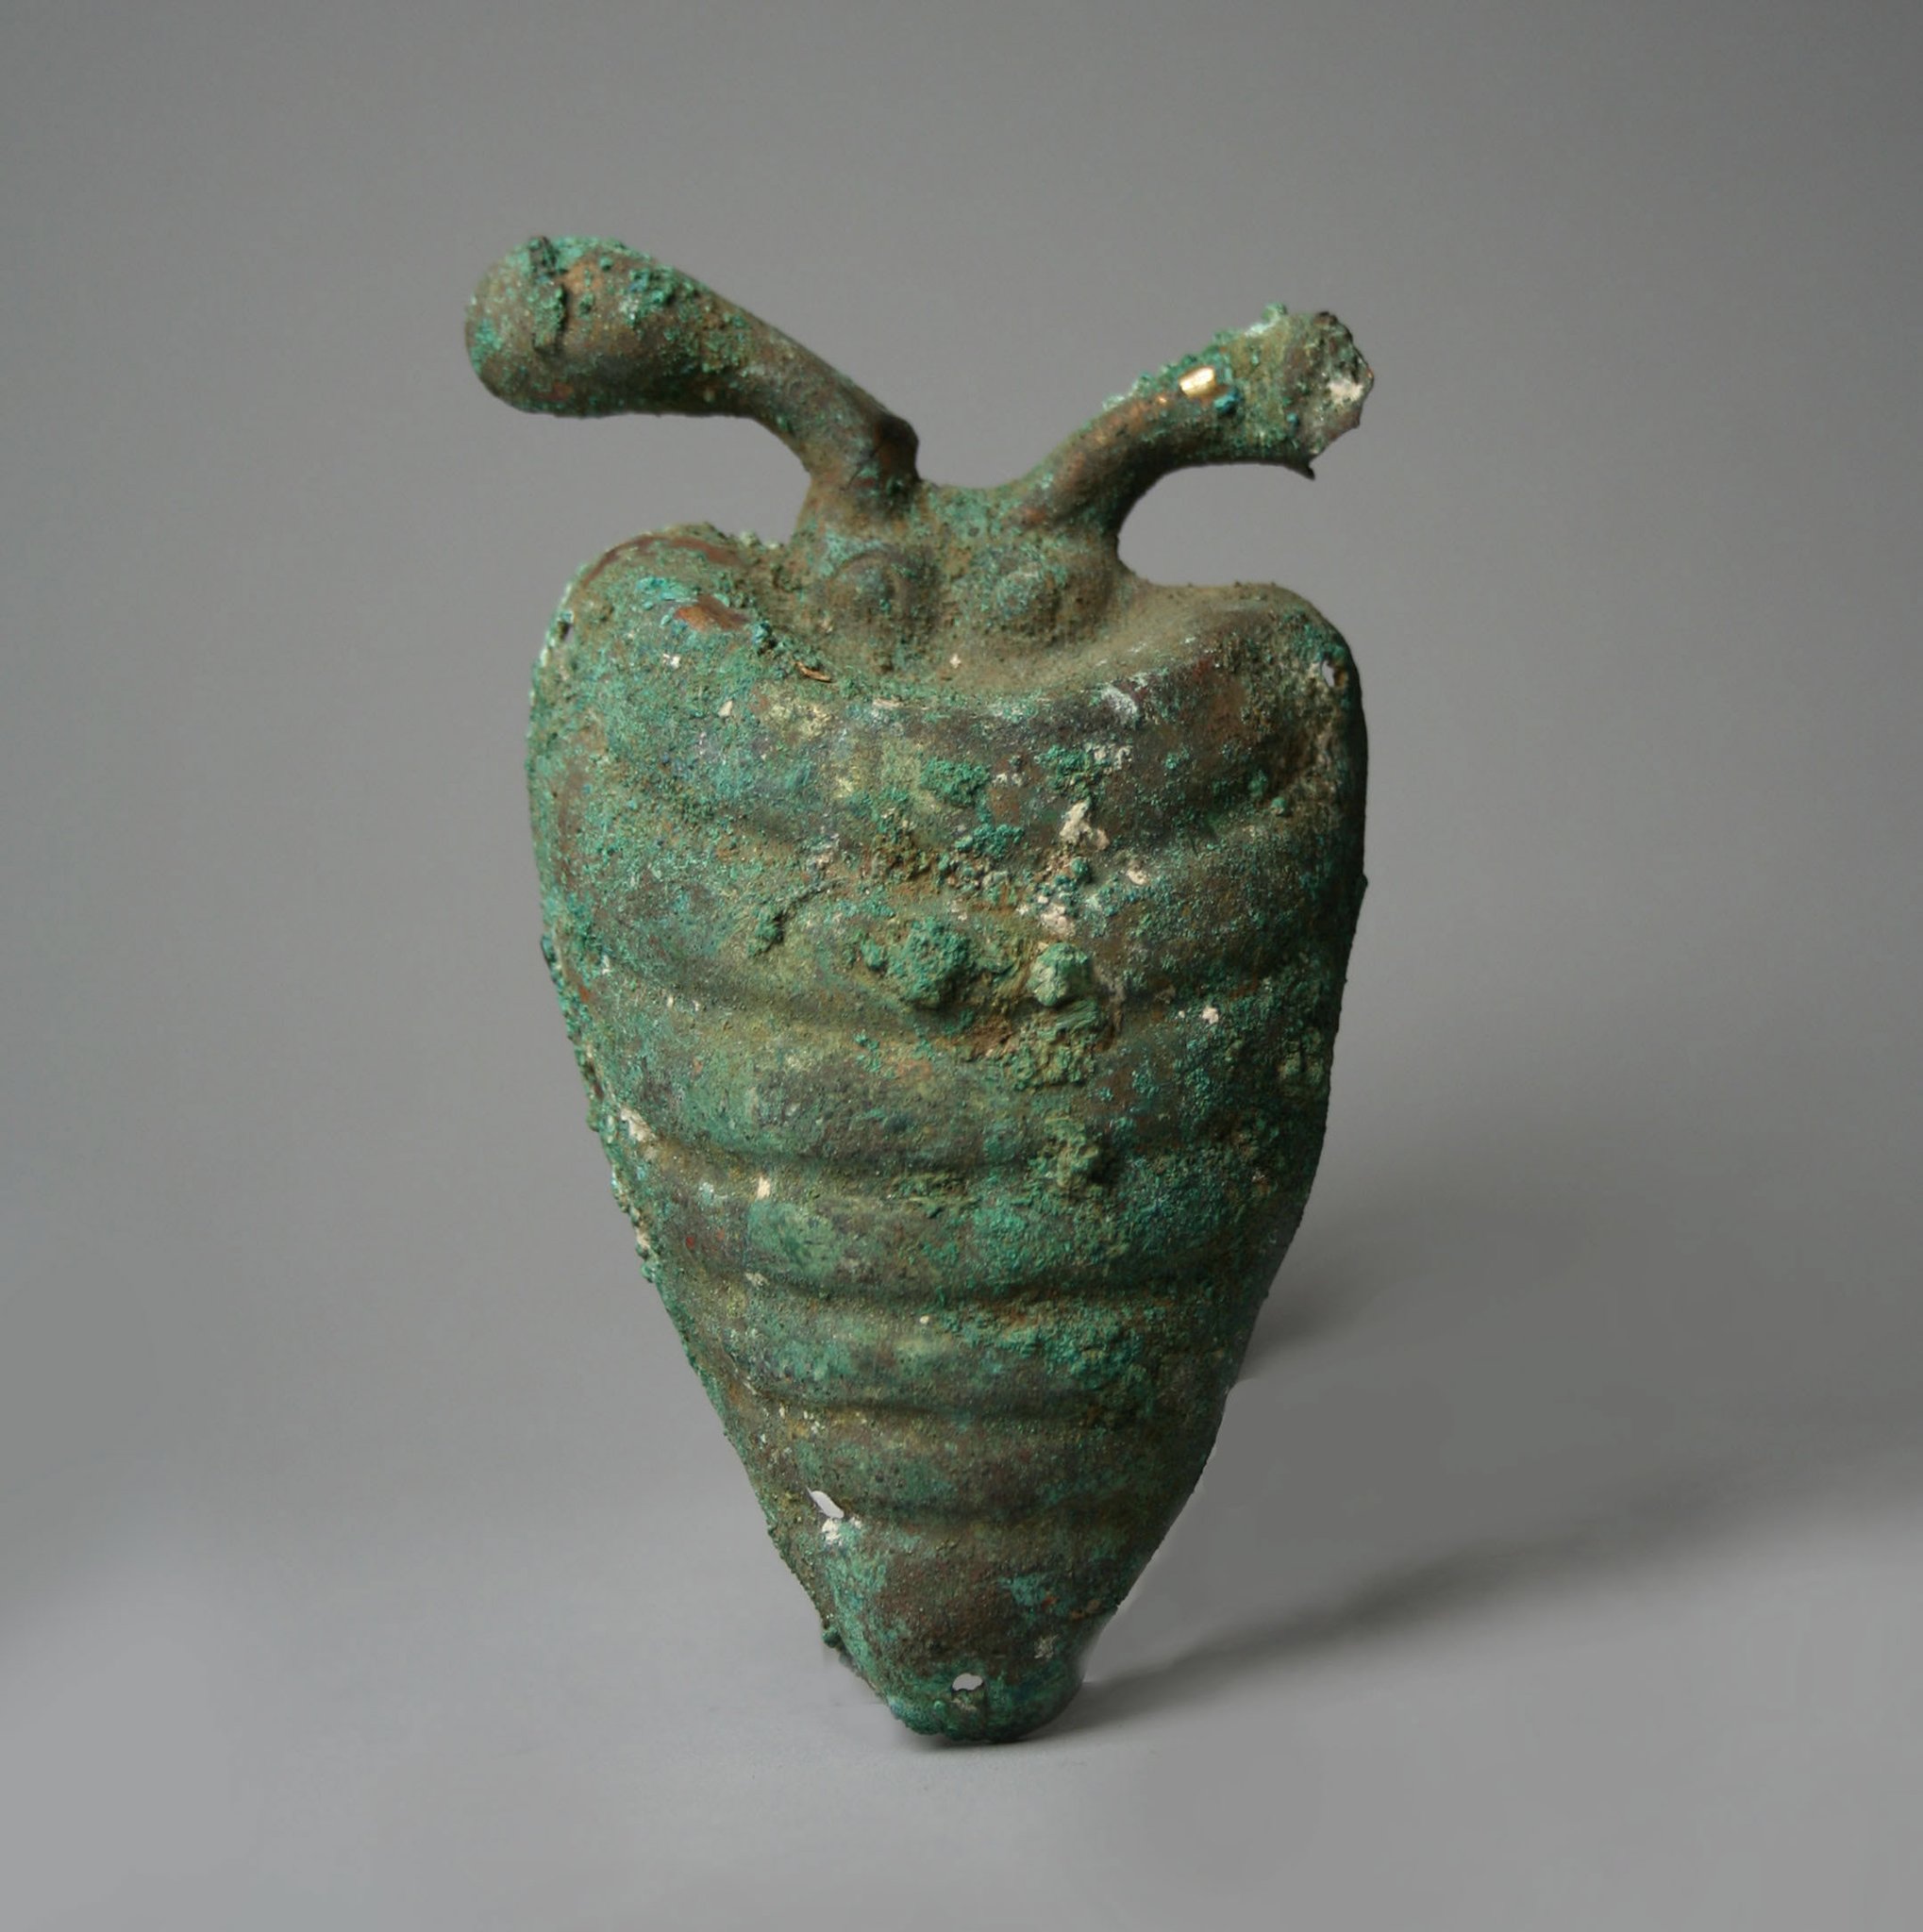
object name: ornament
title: Animal Ornament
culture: moche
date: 501-700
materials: gilt copper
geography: peru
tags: animals